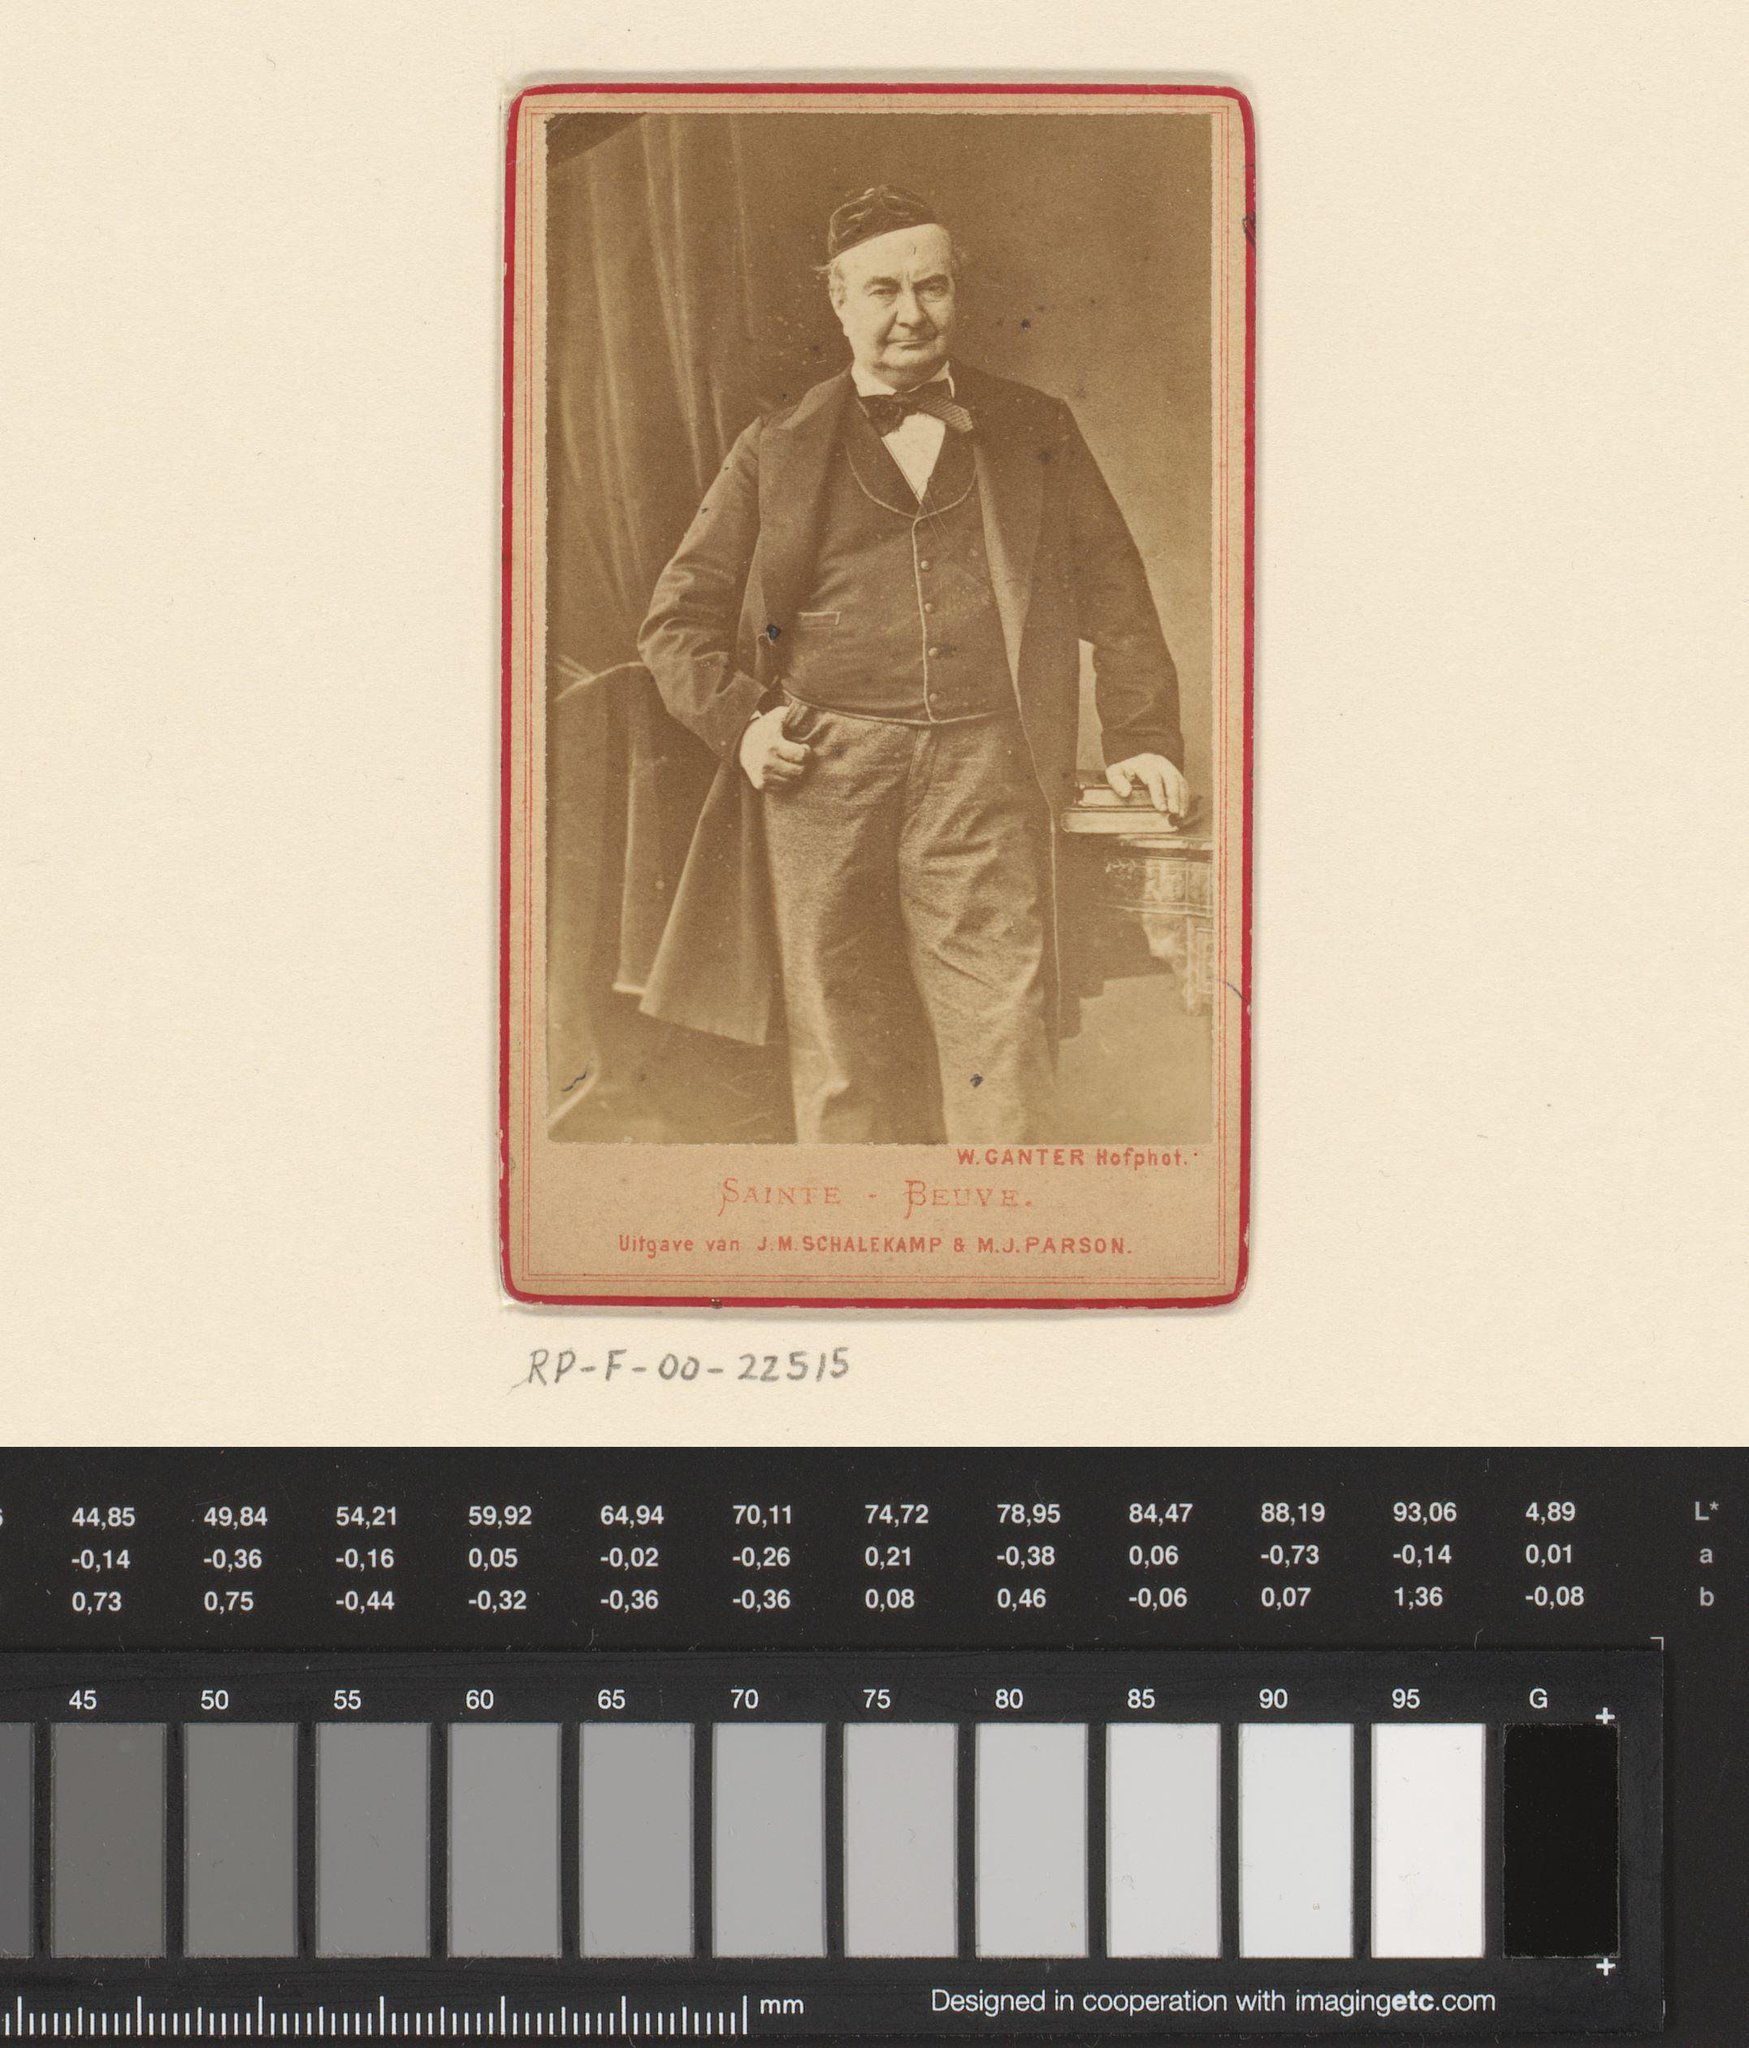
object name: carte de visite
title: Portret van Charles Augustin Sainte-Beuve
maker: w. canter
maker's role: fotograaf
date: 1865-1880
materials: cardboard, paper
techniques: albumen print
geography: haarlem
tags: paris, politician, historical persons, portrait of a writer